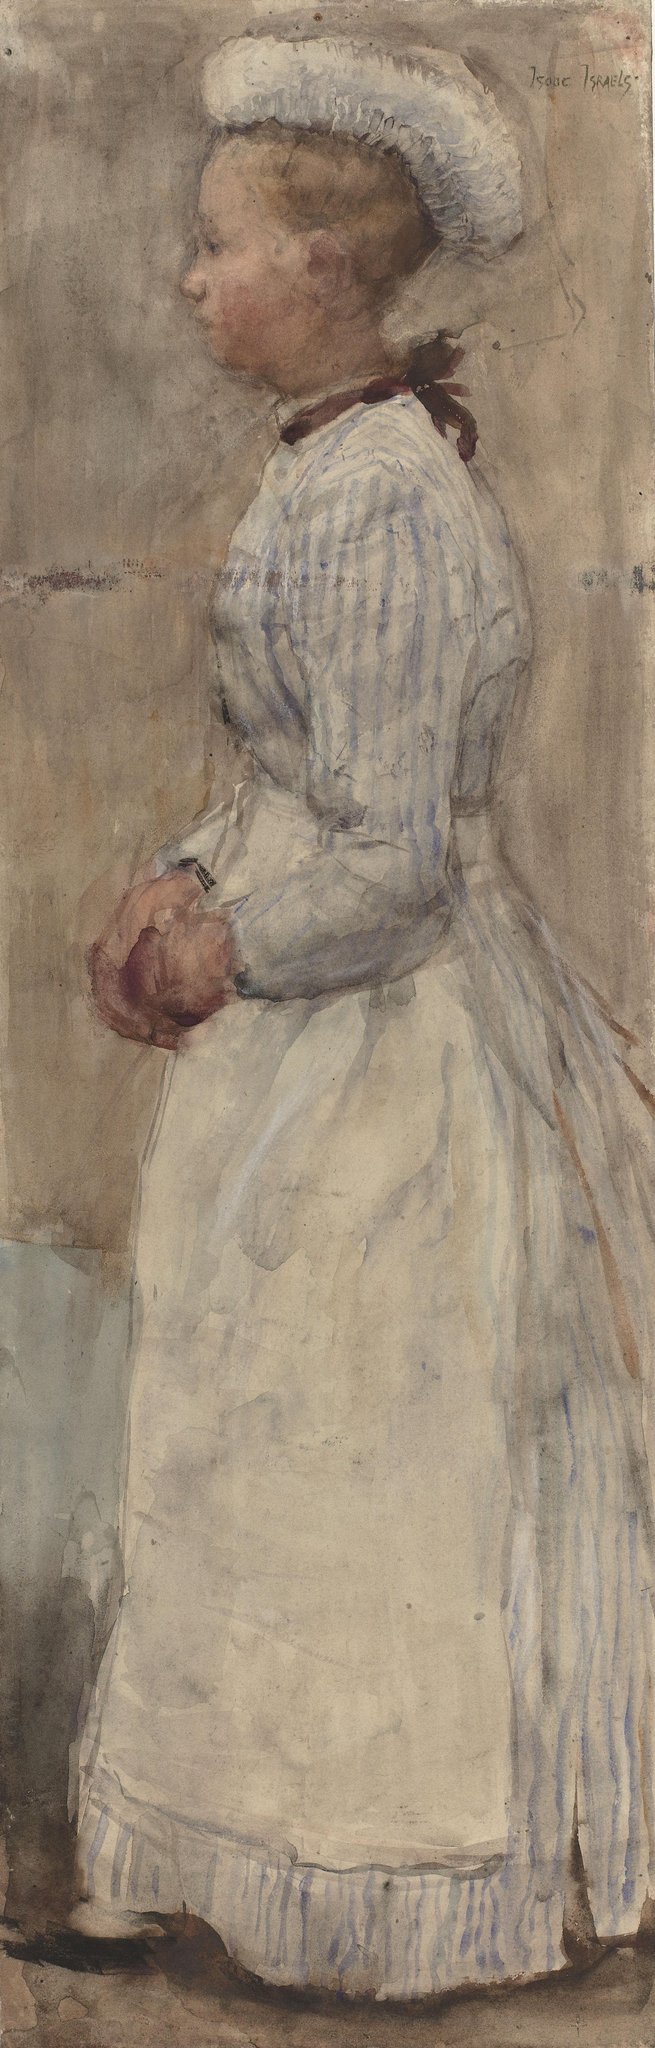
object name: watercolor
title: Dienstmeisje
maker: isaac israels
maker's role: draughtsman, painter, print maker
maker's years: 1865-1934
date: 1875-1934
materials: paper, watercolor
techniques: brush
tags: maid ~ house personnel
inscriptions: signature: ‘Isaac Israels’